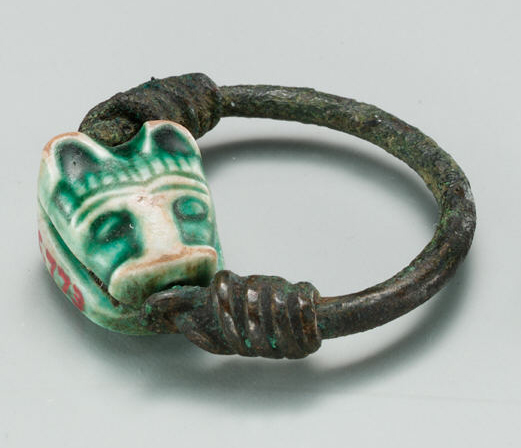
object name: ring, design amulet, feline head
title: Ring with a Feline's Head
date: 1550-1425 BCE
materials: copper, stone, metal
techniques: glazing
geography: egypt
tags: cats